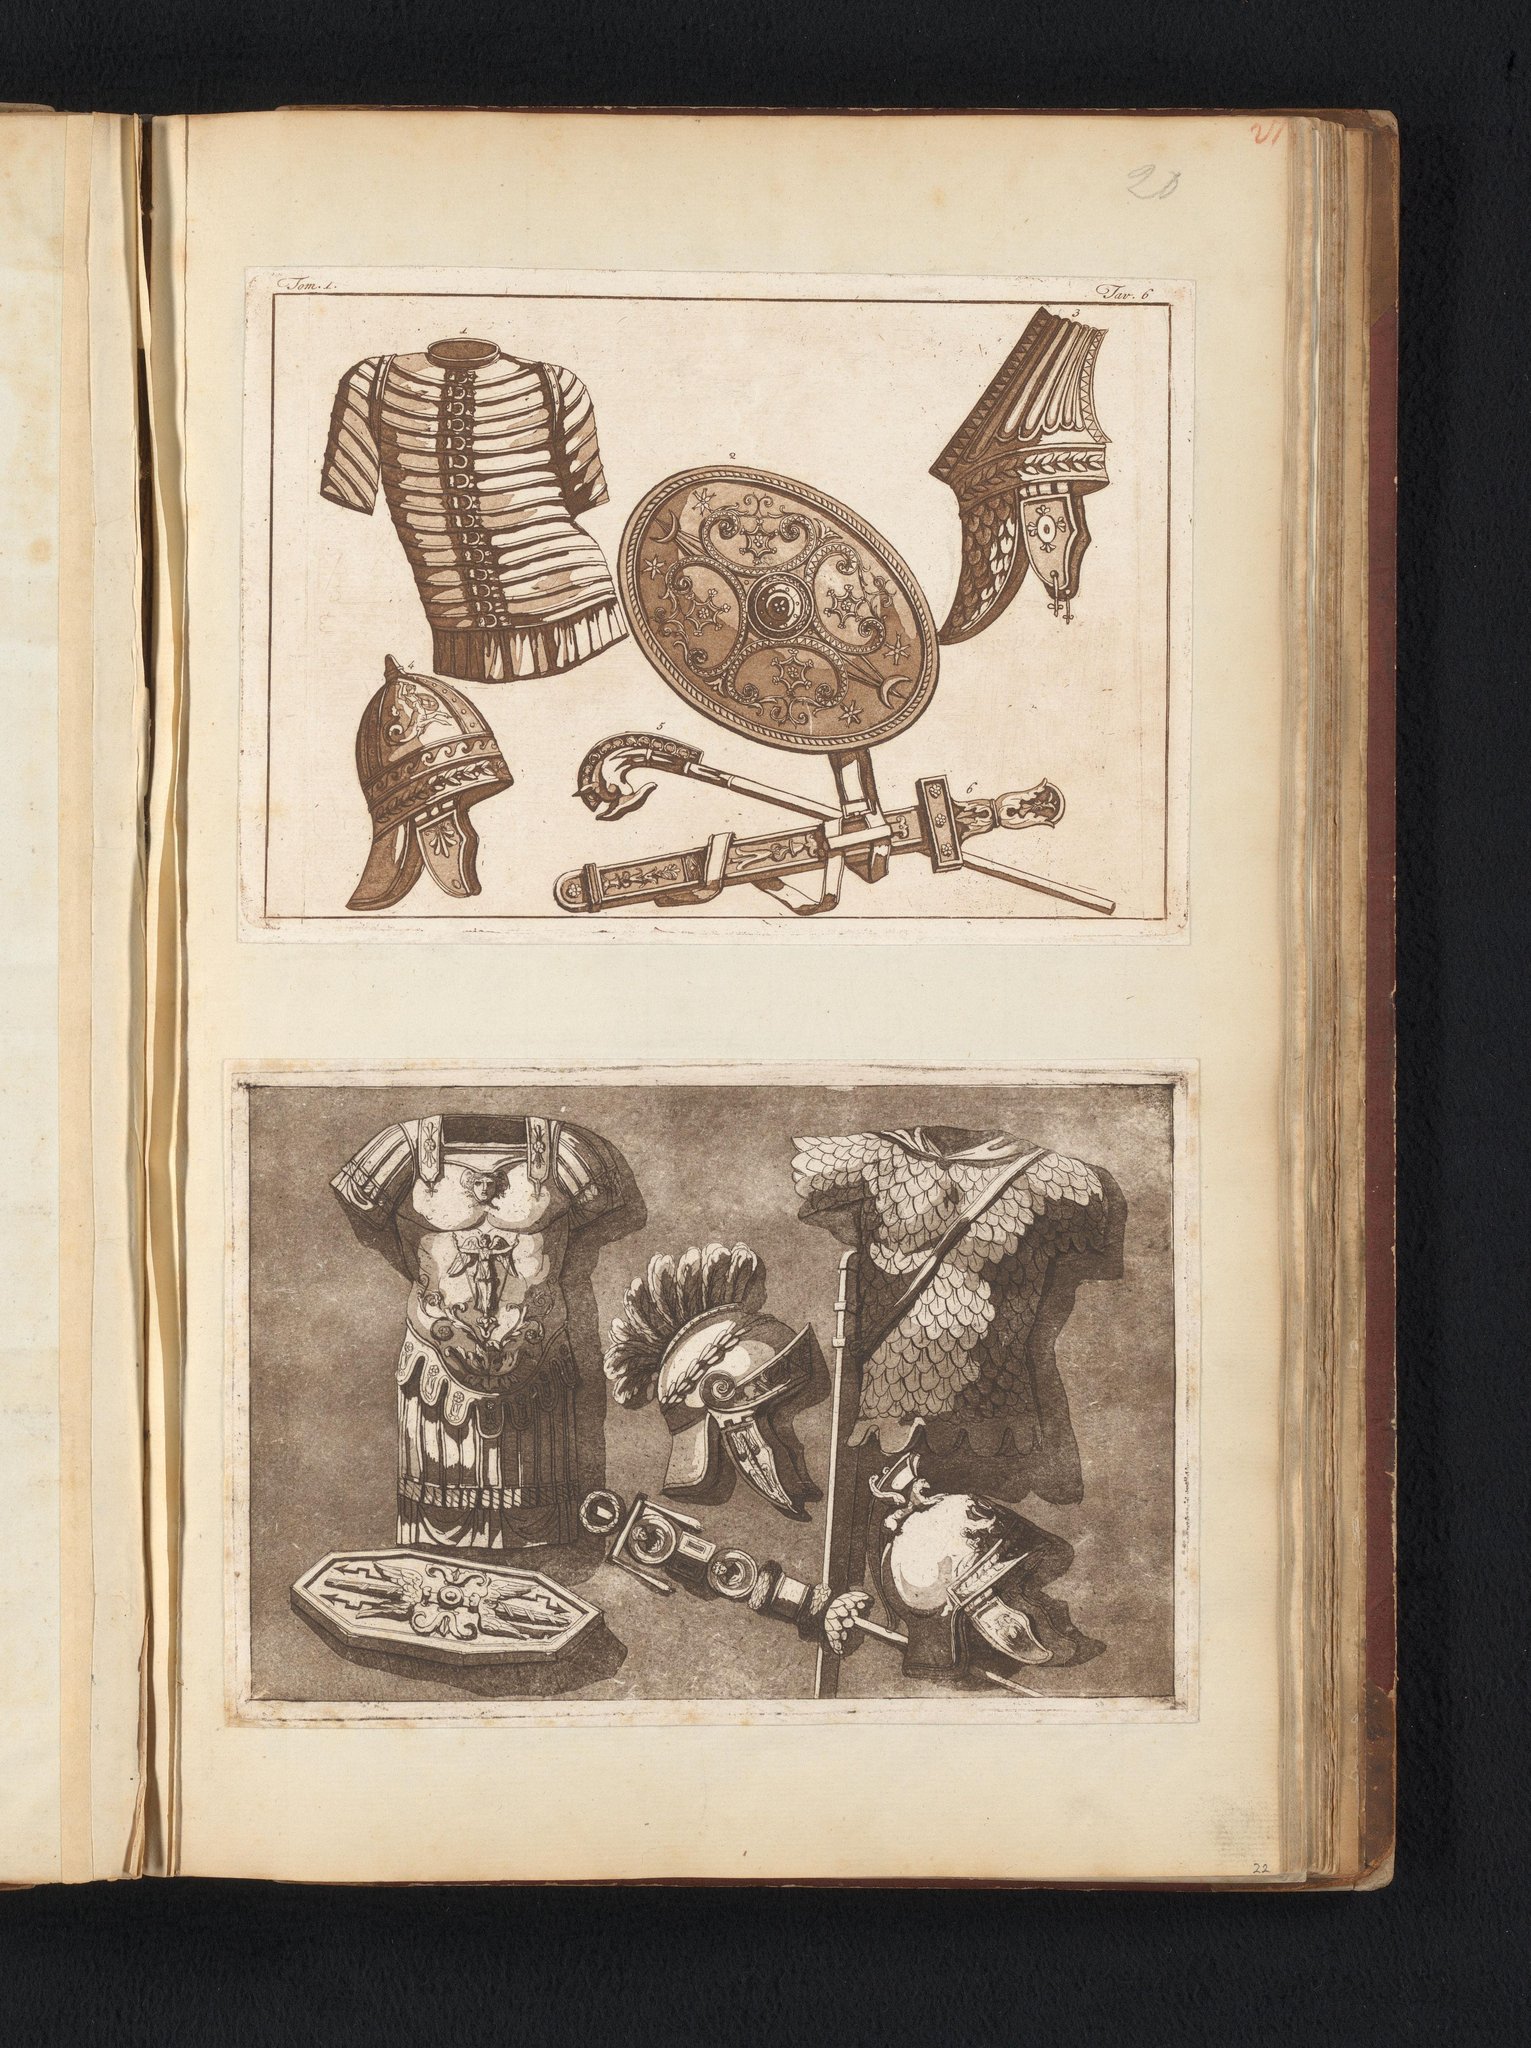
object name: print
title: Antieke wapenrusting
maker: Anonymous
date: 1750-1816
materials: paper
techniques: aquatint, etching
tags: armour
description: Twee platen van onderdelen van antieke wapenrusting. Onderdeel van het tweede van twee albums met ingeplakte prenten en tekeningen te dienen als tekenvoorbeelden.